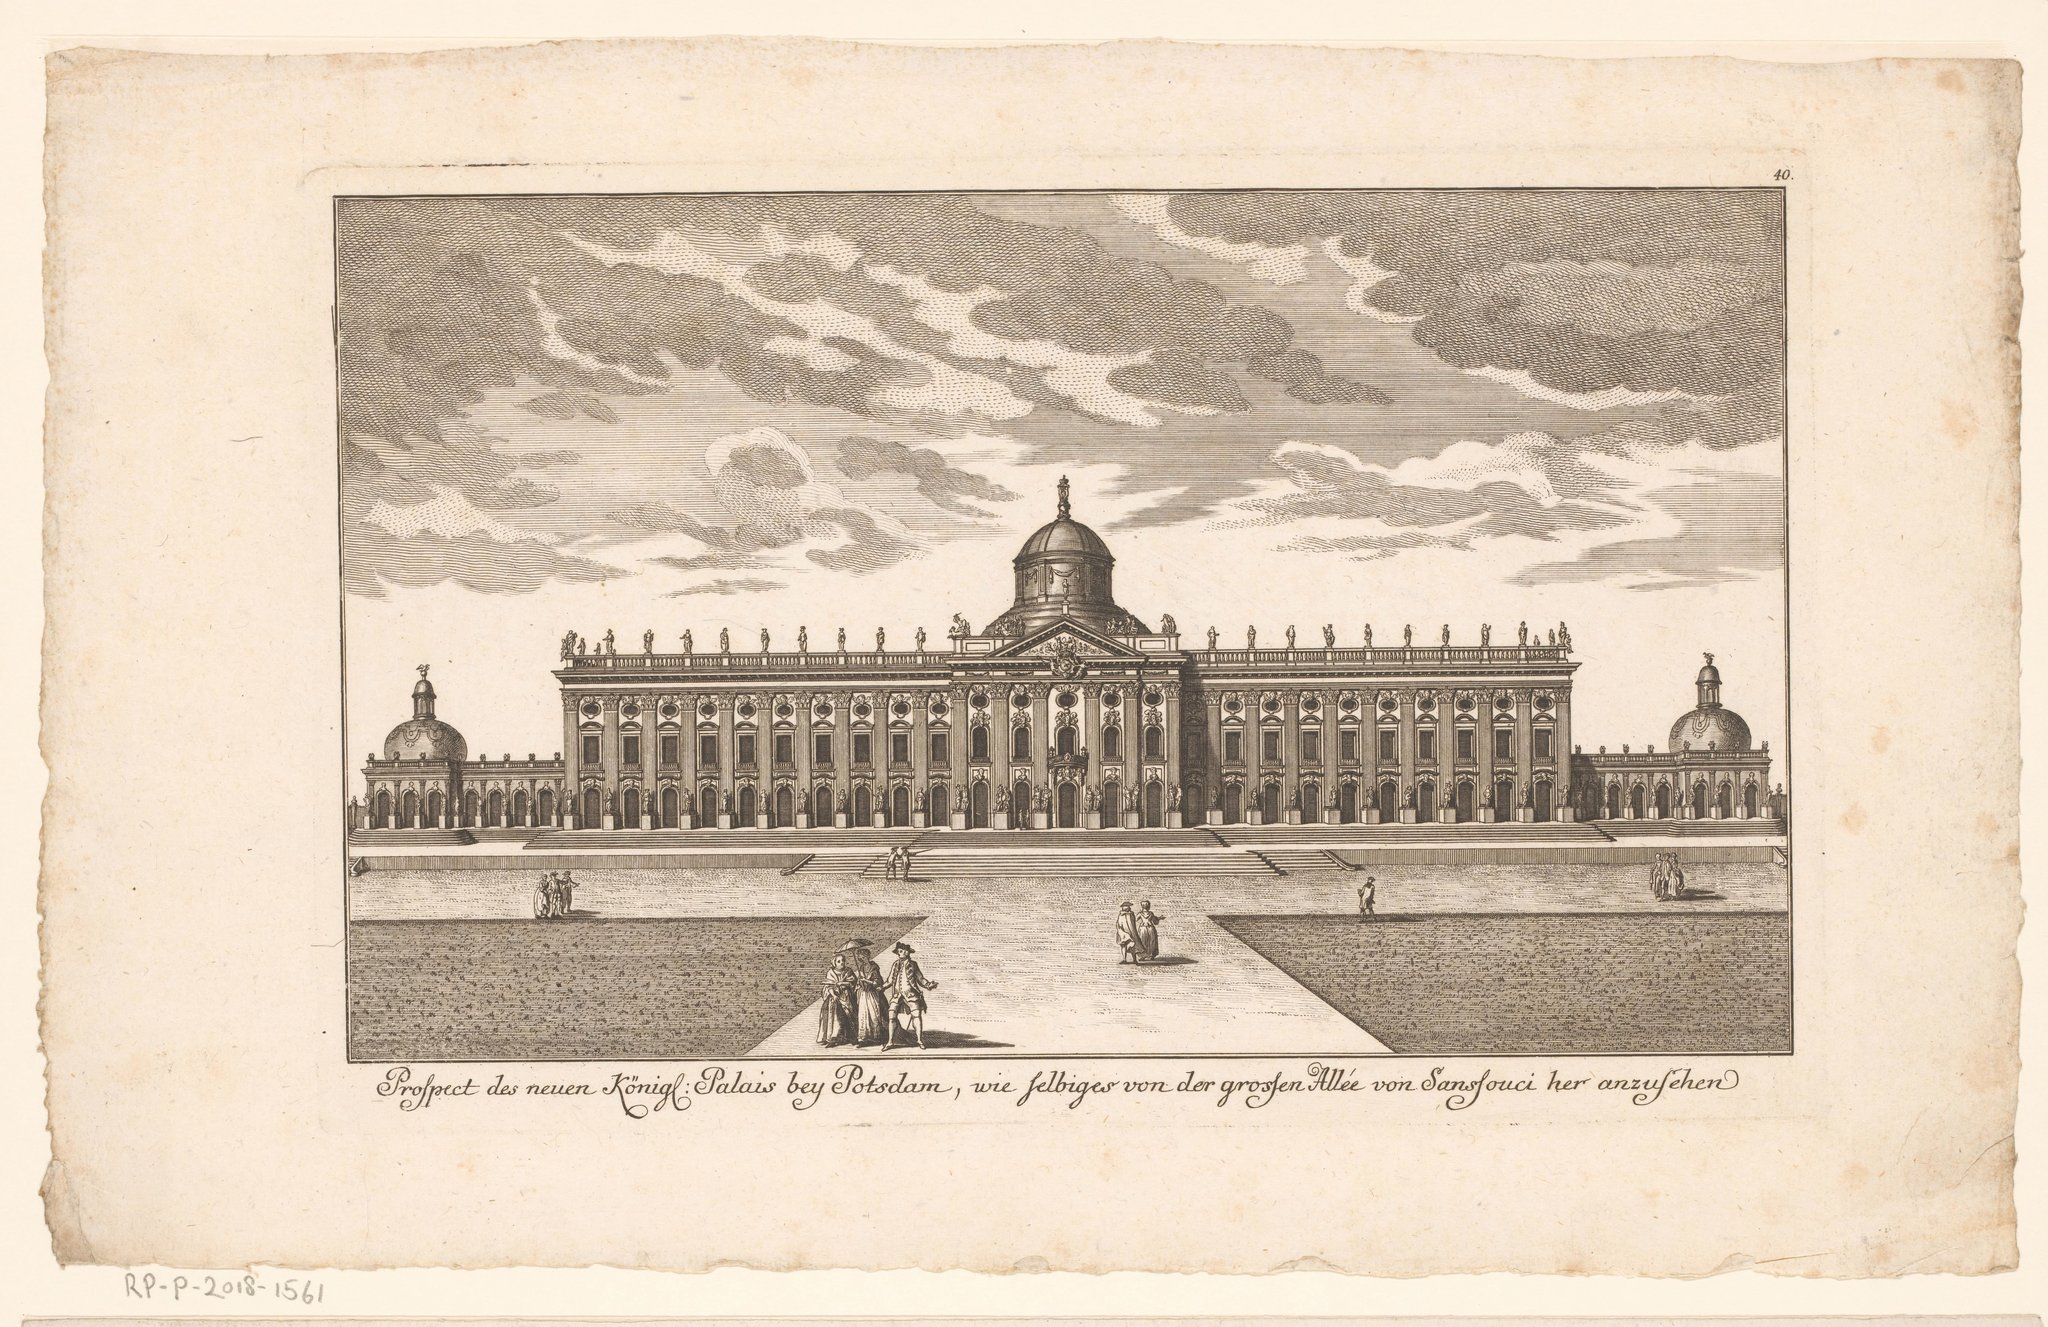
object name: print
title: Gezicht op het Potsdamer Stadtschloss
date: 1751-1774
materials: paper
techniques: engraving, etching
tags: castle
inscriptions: collector's mark: Lugt 2228